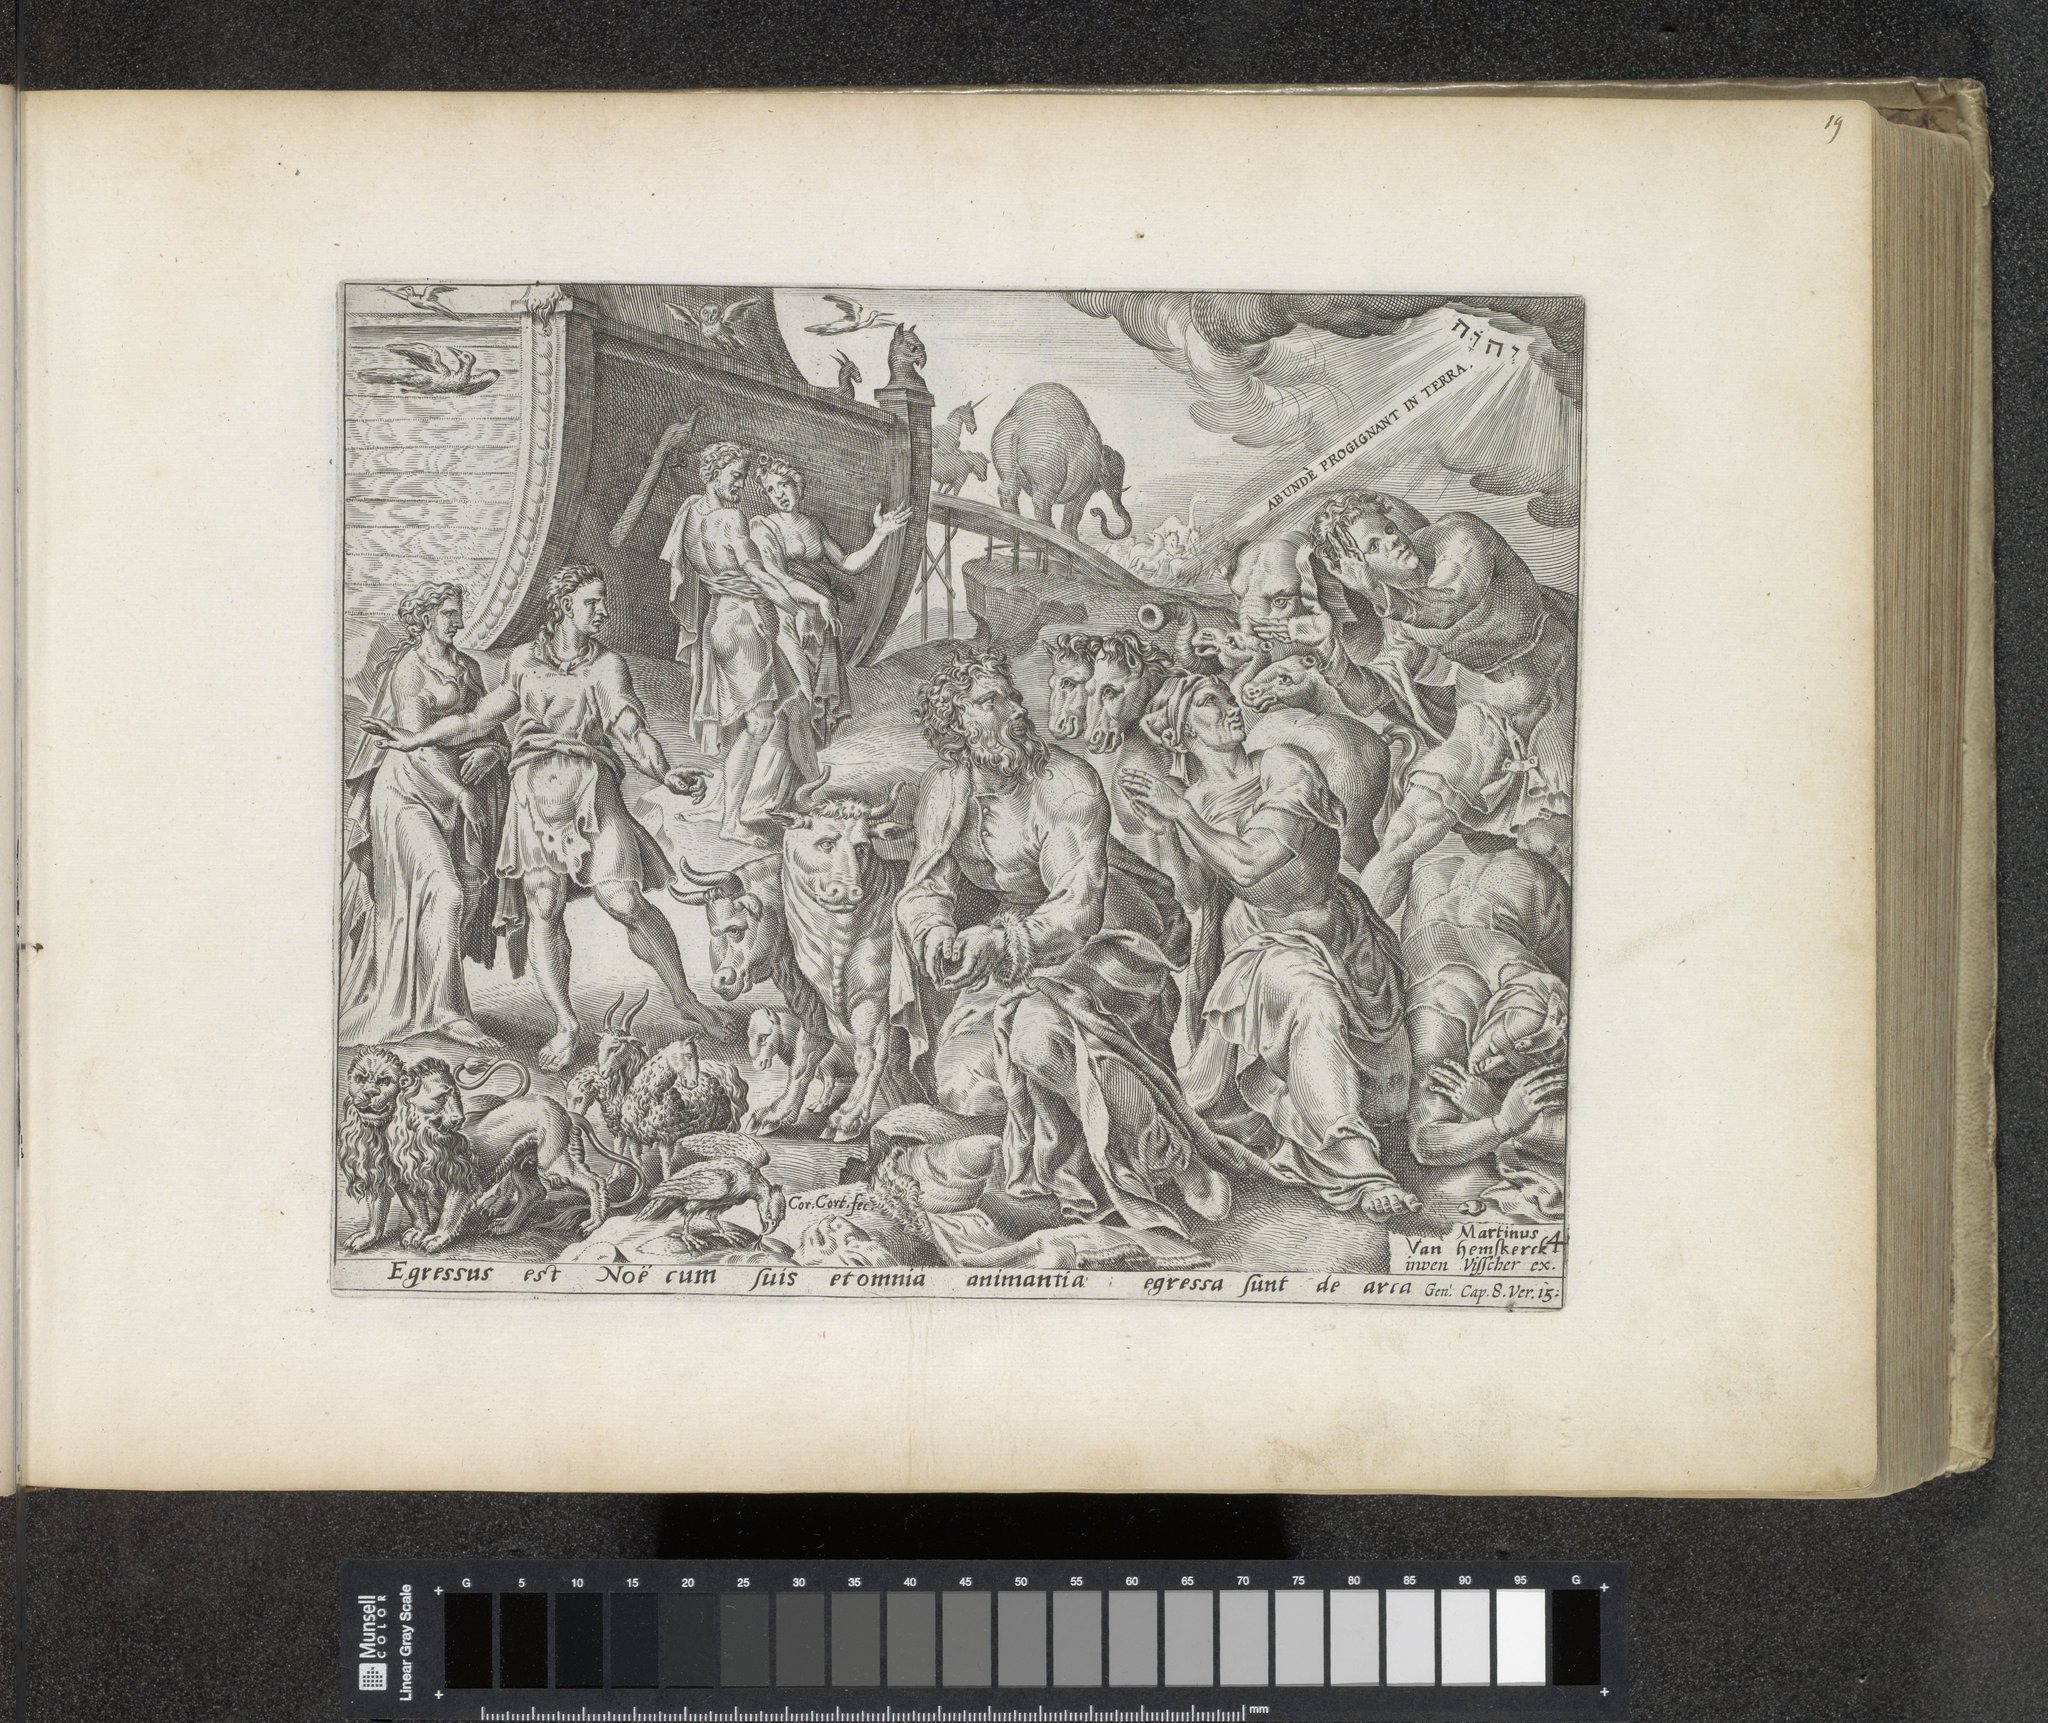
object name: print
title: Noach dankt God voor de redding van de ark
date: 1558-1560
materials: paper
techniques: engraving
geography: amsterdam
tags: noah, his family and the animals leave the ark (sometimes combined with the rainbow of the covenant)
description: Noach en zijn familie knielen op de grond en kijken op naar het tetragram, het symbool voor God (een lichtende cirkel met de Hebreeuwse letters voor Jahweh) boven hen in een wolk. Linksachter de ark, waaruit de dieren over een loopbrug aan land gaan. Onderaan een verwijzing naar de Bijbeltekst in Gen. 7:10 in het Latijn. Deze prent maakt deel uit van een album.